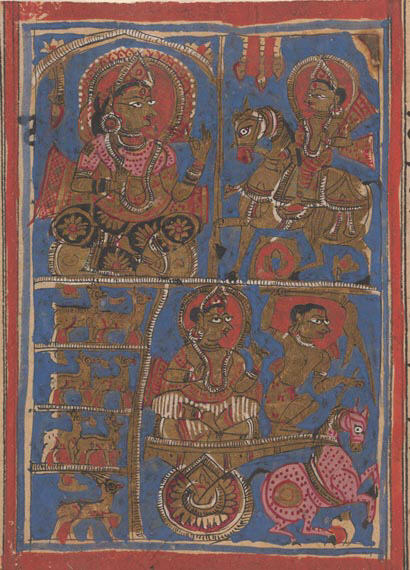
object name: folio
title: Aristanemi's Bridal Pavilion (top) and Witnessing Animals for Slaughter (bottom): Folio from a Kalpasutra Manuscript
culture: indian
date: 1401-1500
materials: gold, ink, paper, watercolor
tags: animals,men,women,horses,chariots